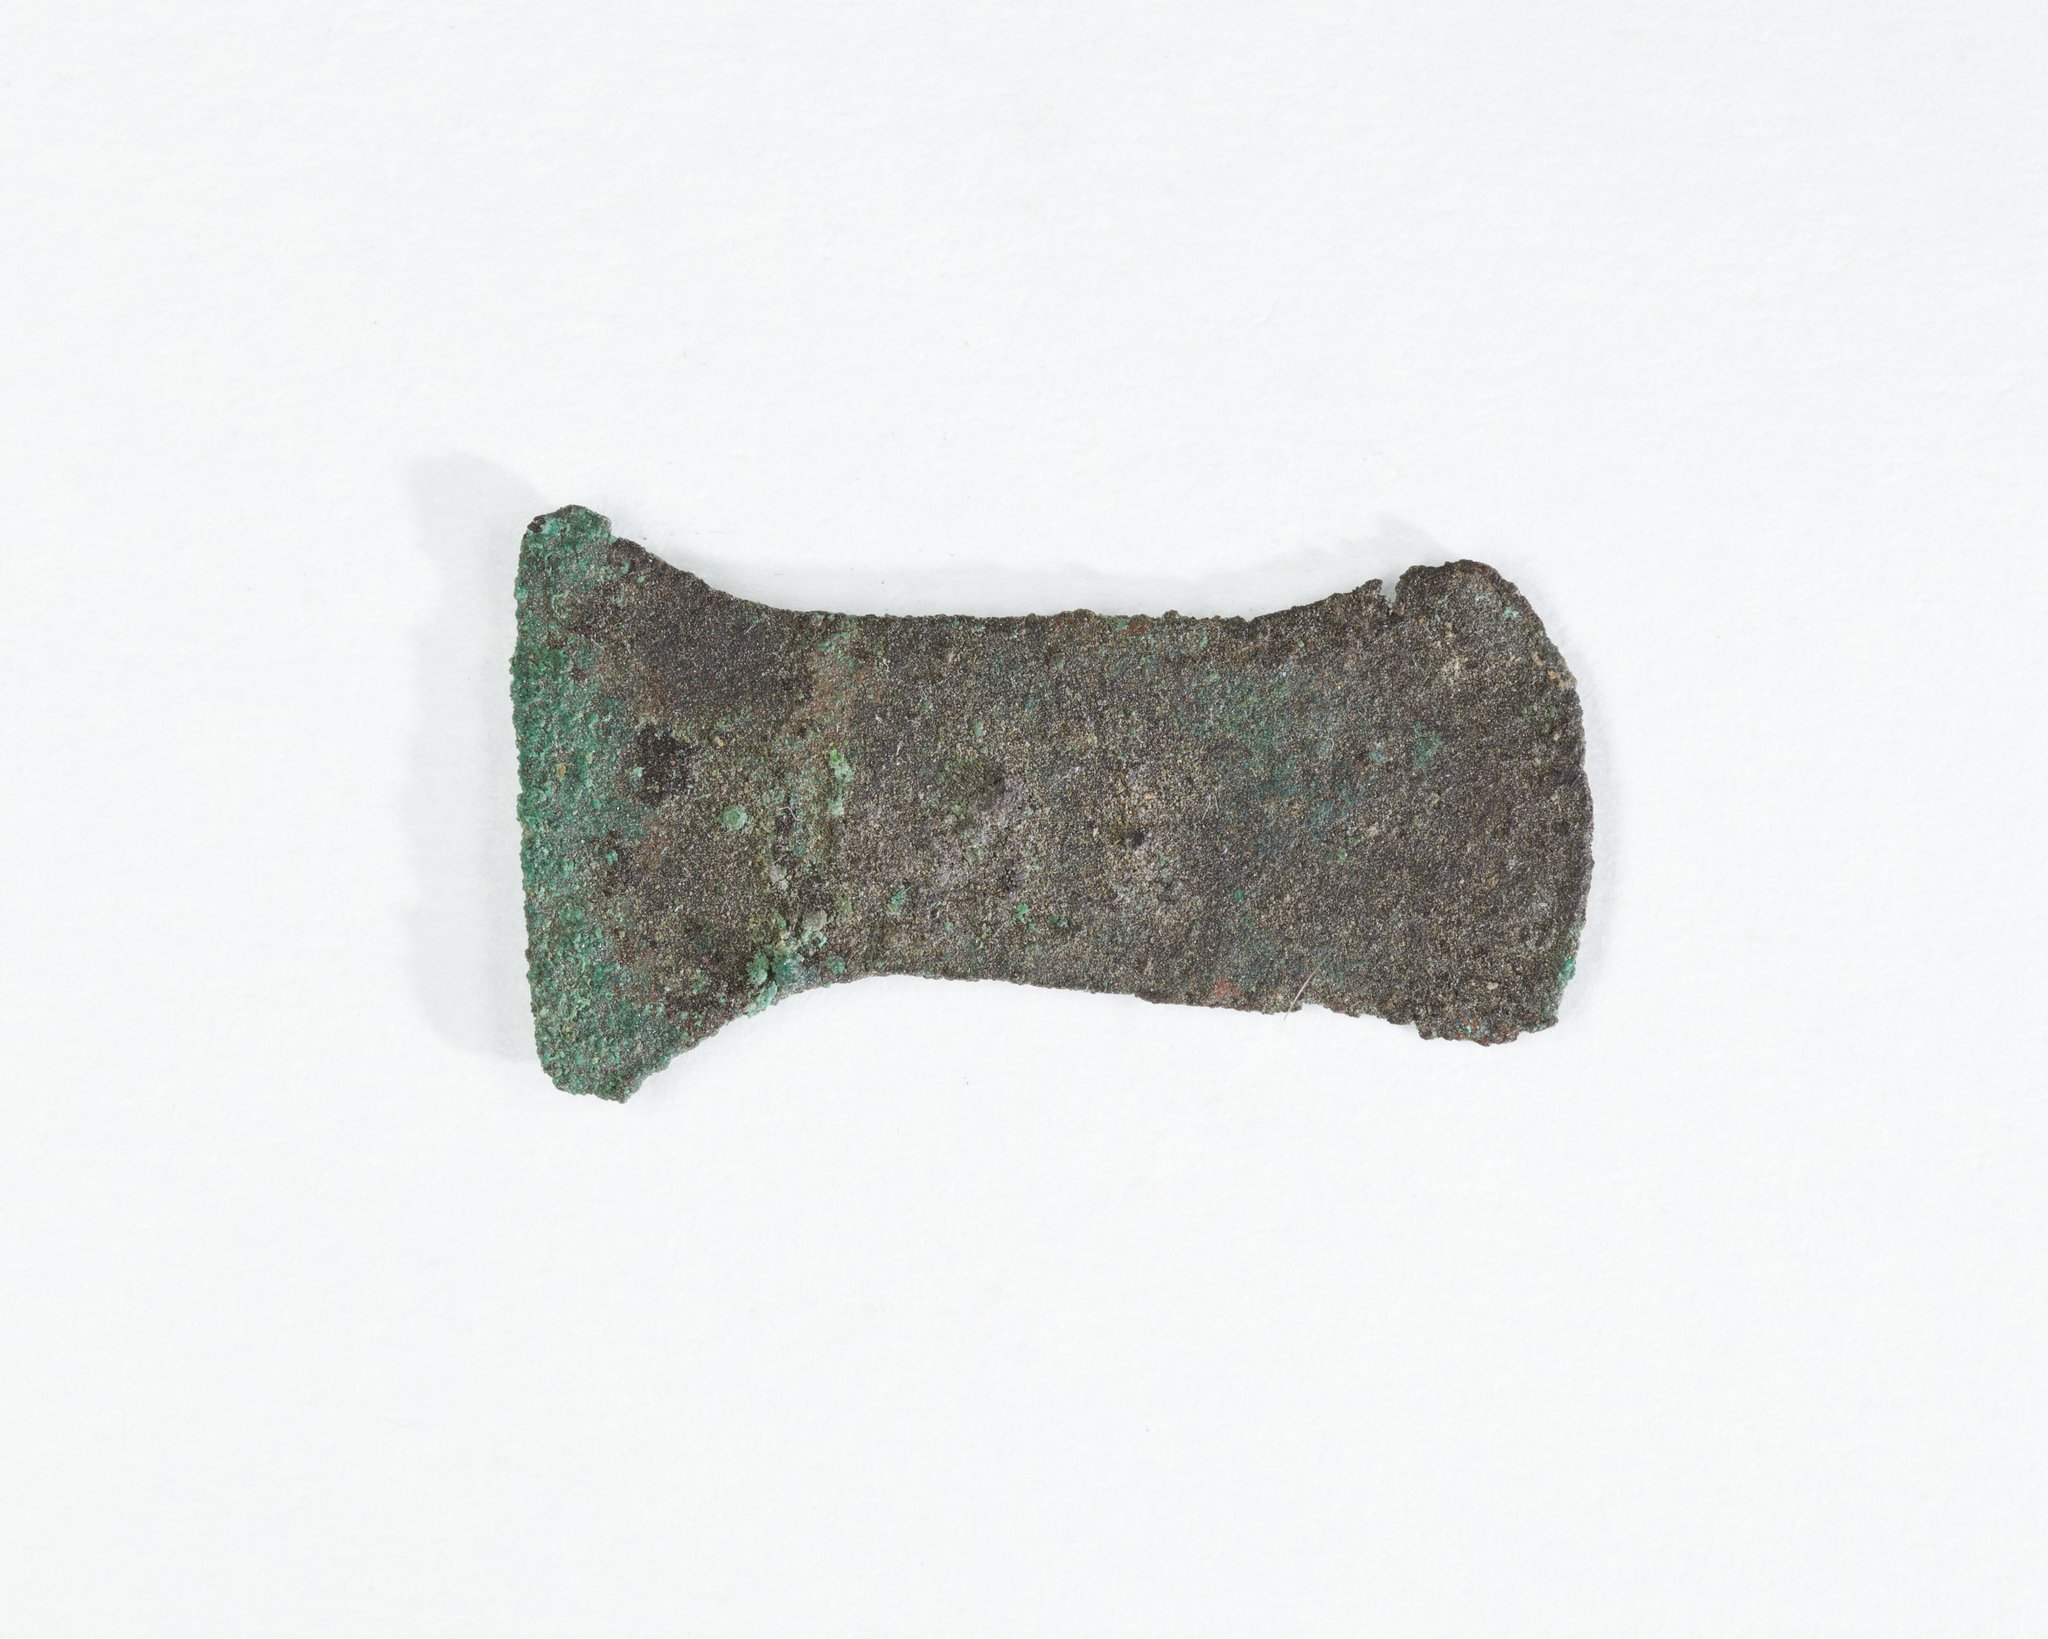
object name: ax blade, model, tool, senenmut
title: Blade for a Model Axe from a Foundation Deposit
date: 1479-1458 BCE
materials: bronze, copper alloy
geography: egypt